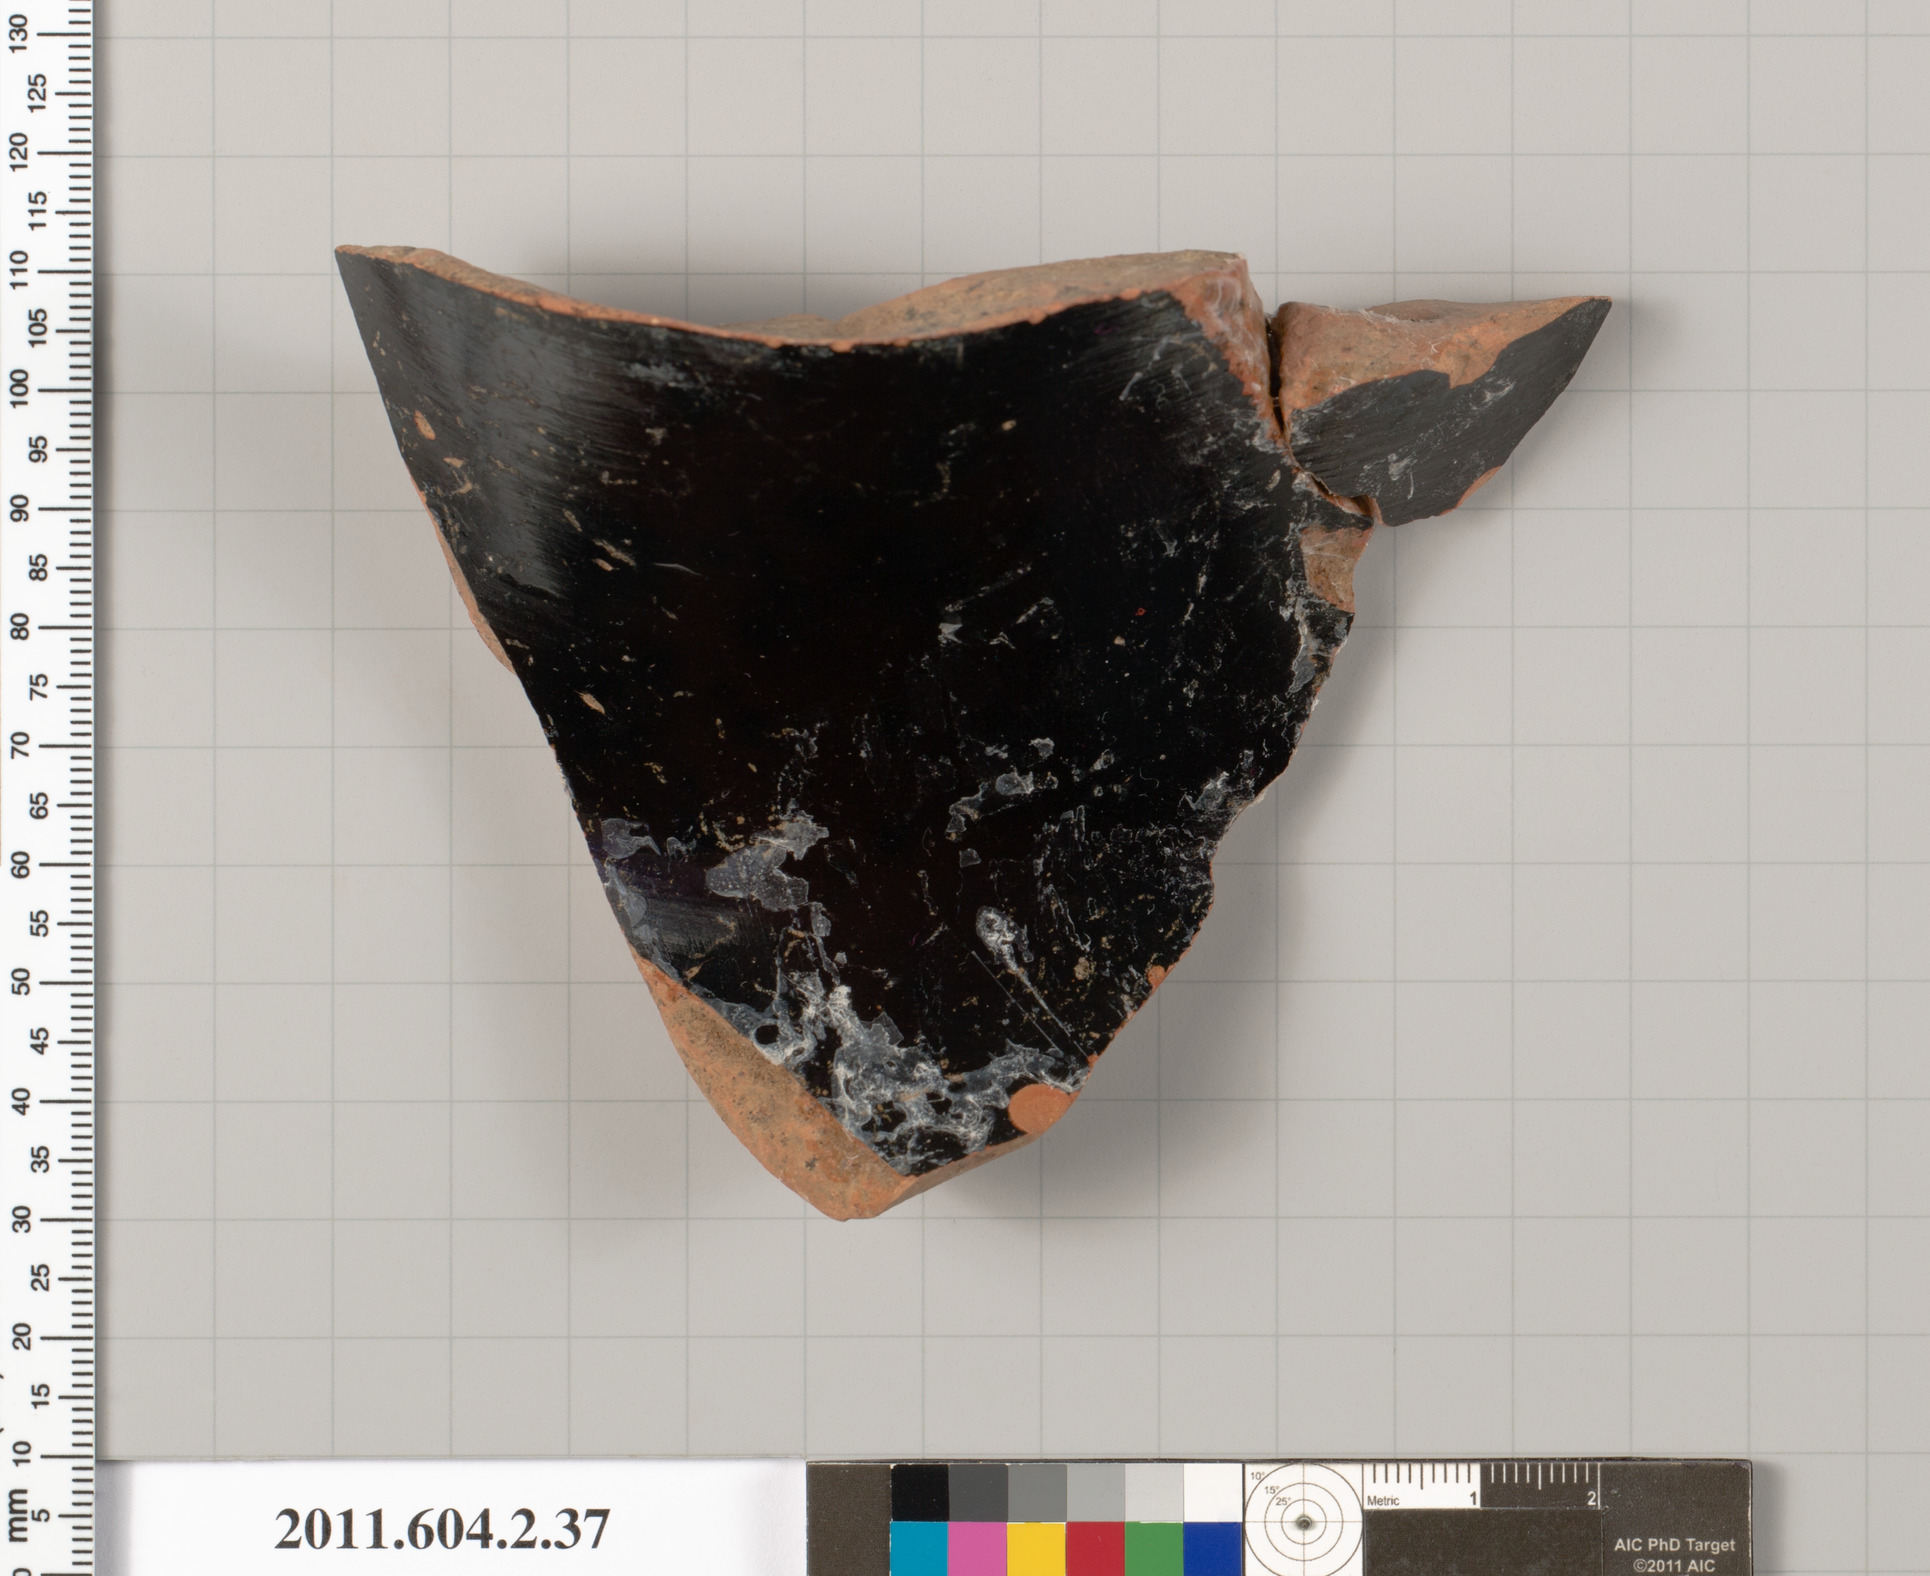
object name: psykter fragment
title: Terracotta fragment of a psykter? (vase for cooling wine)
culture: greek, attic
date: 534-468 BCE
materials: terracotta